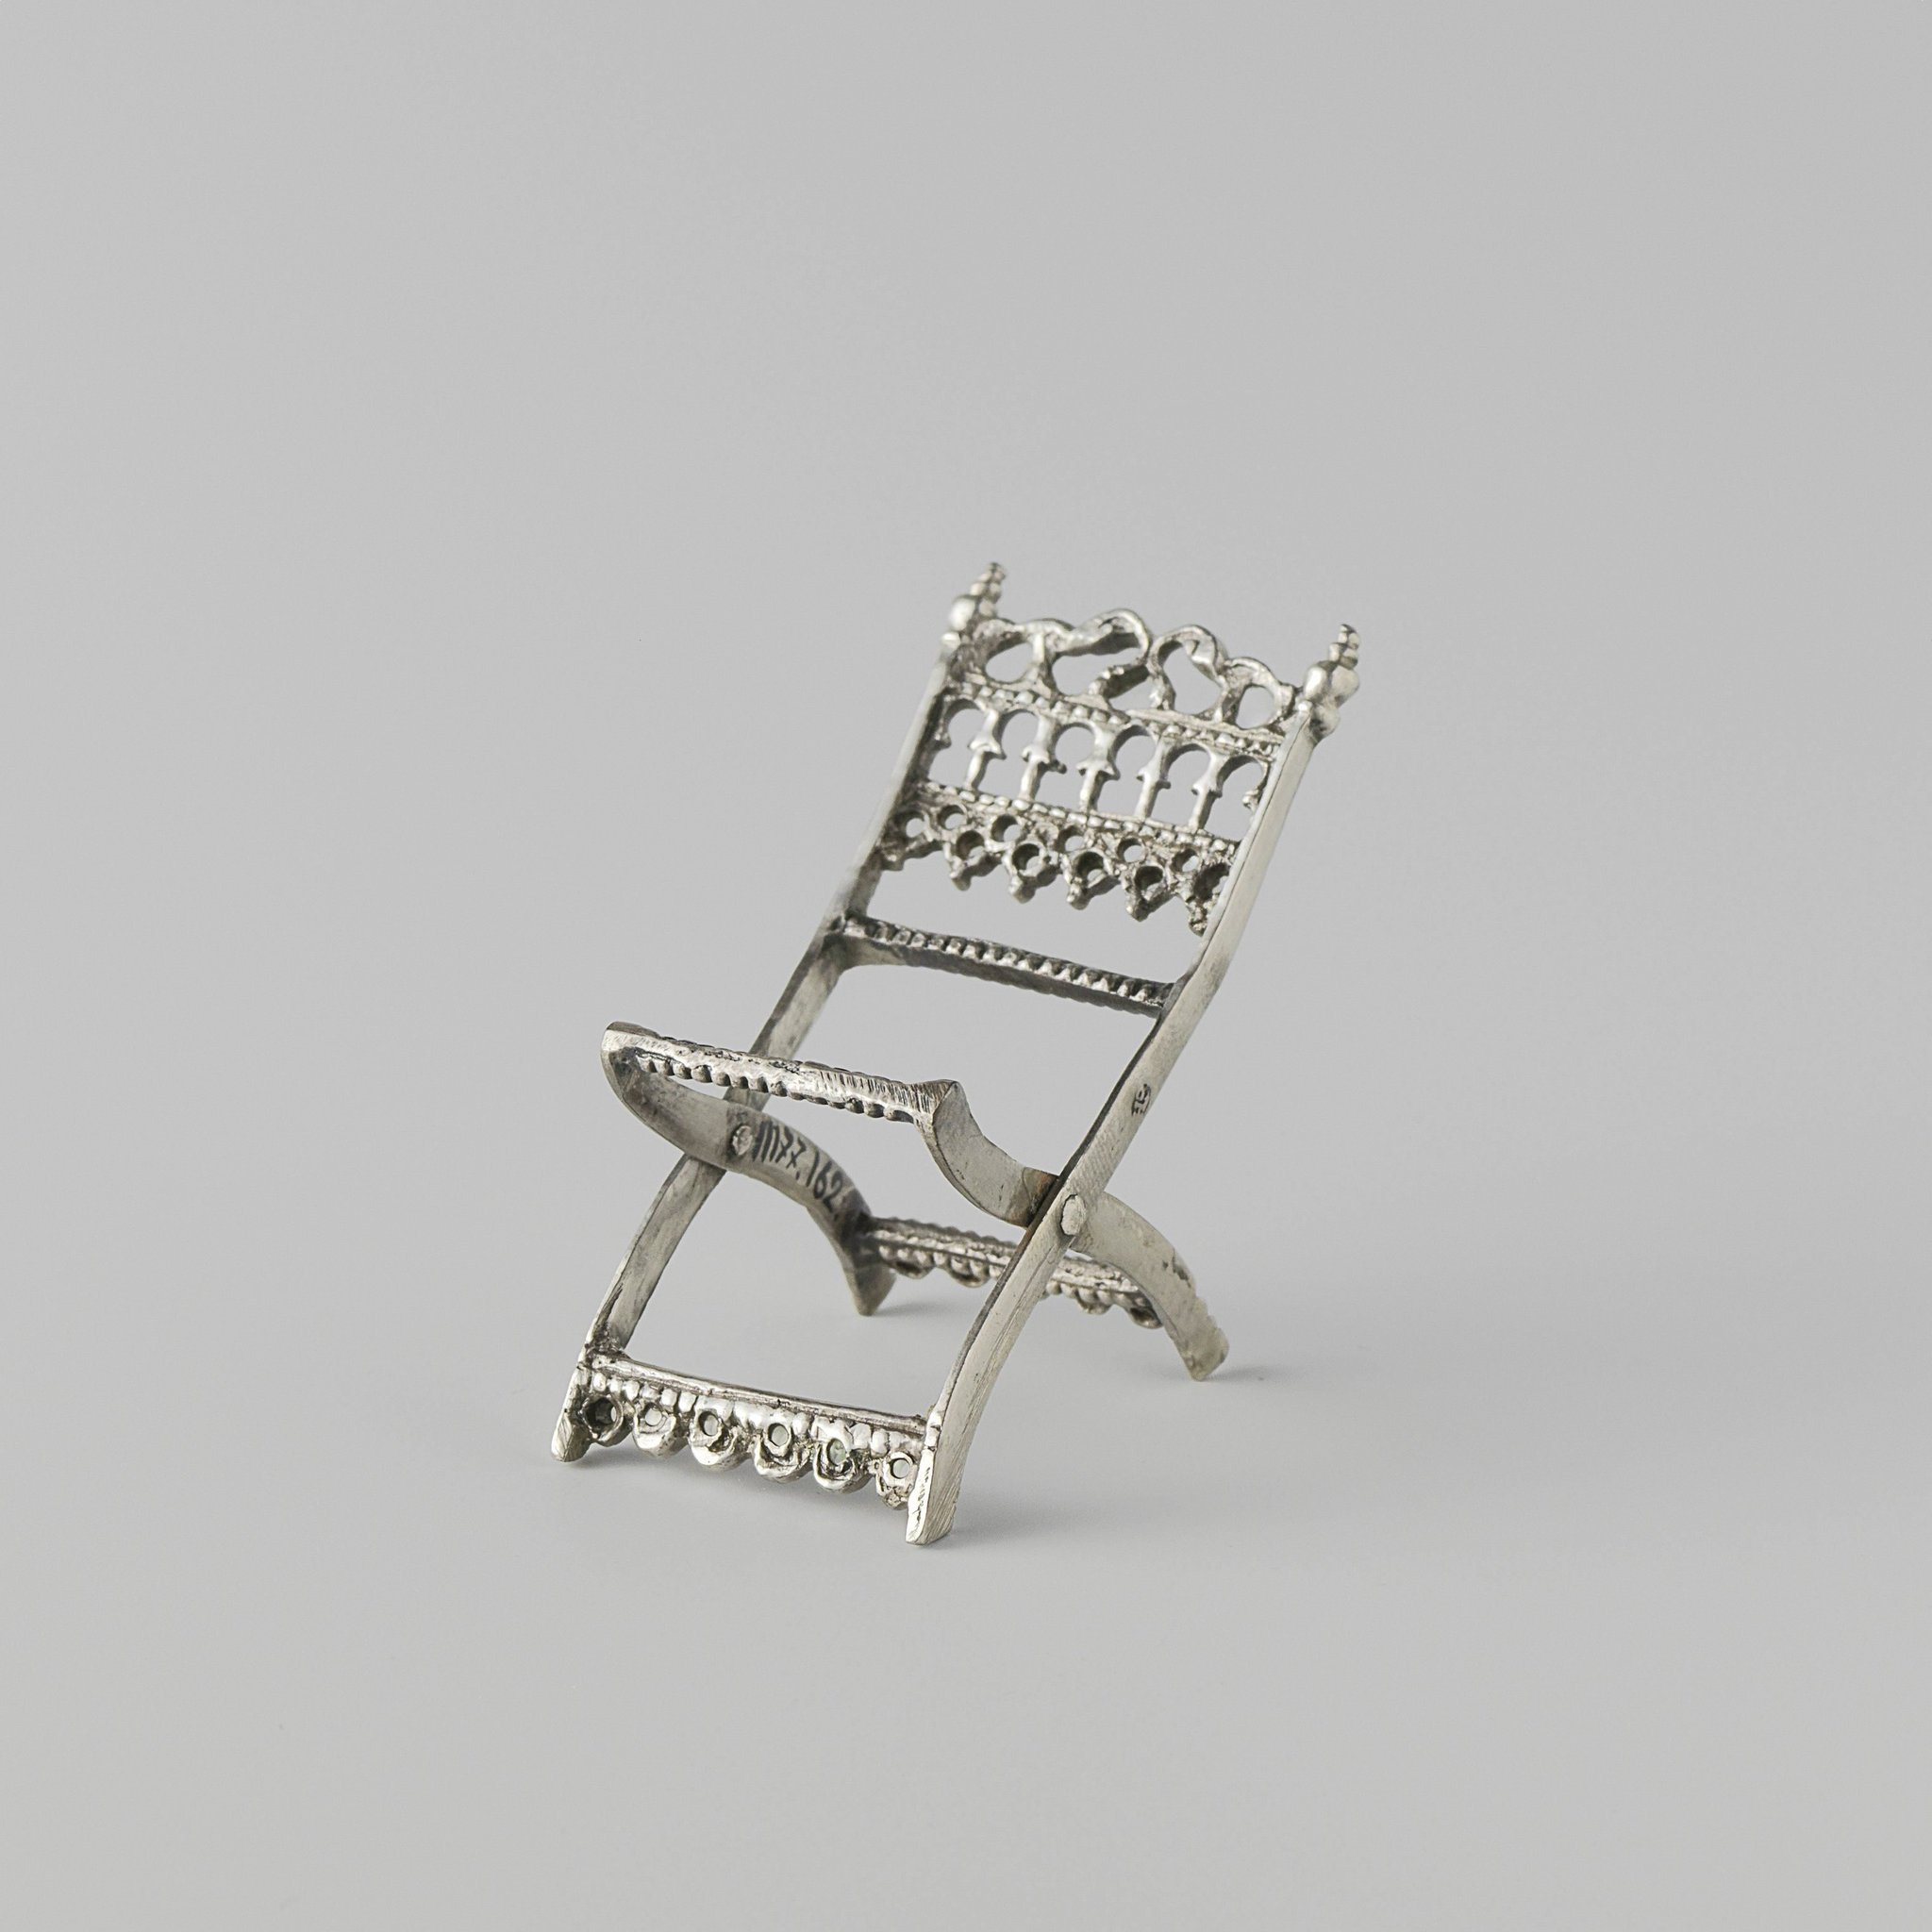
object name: miniature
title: Kerkstoel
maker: Anonymous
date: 1650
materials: silver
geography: netherlands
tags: (liturgical) equipment of church, chair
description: Opvouwbare stoel met opengewerkte rugleuning. De rode fluwelen zitting ontbreekt. De sporten tussen de poten zijn opengewerkt. De stoel is gemerkt: de letters HLO of HB en tweemaal een zwijnskop.